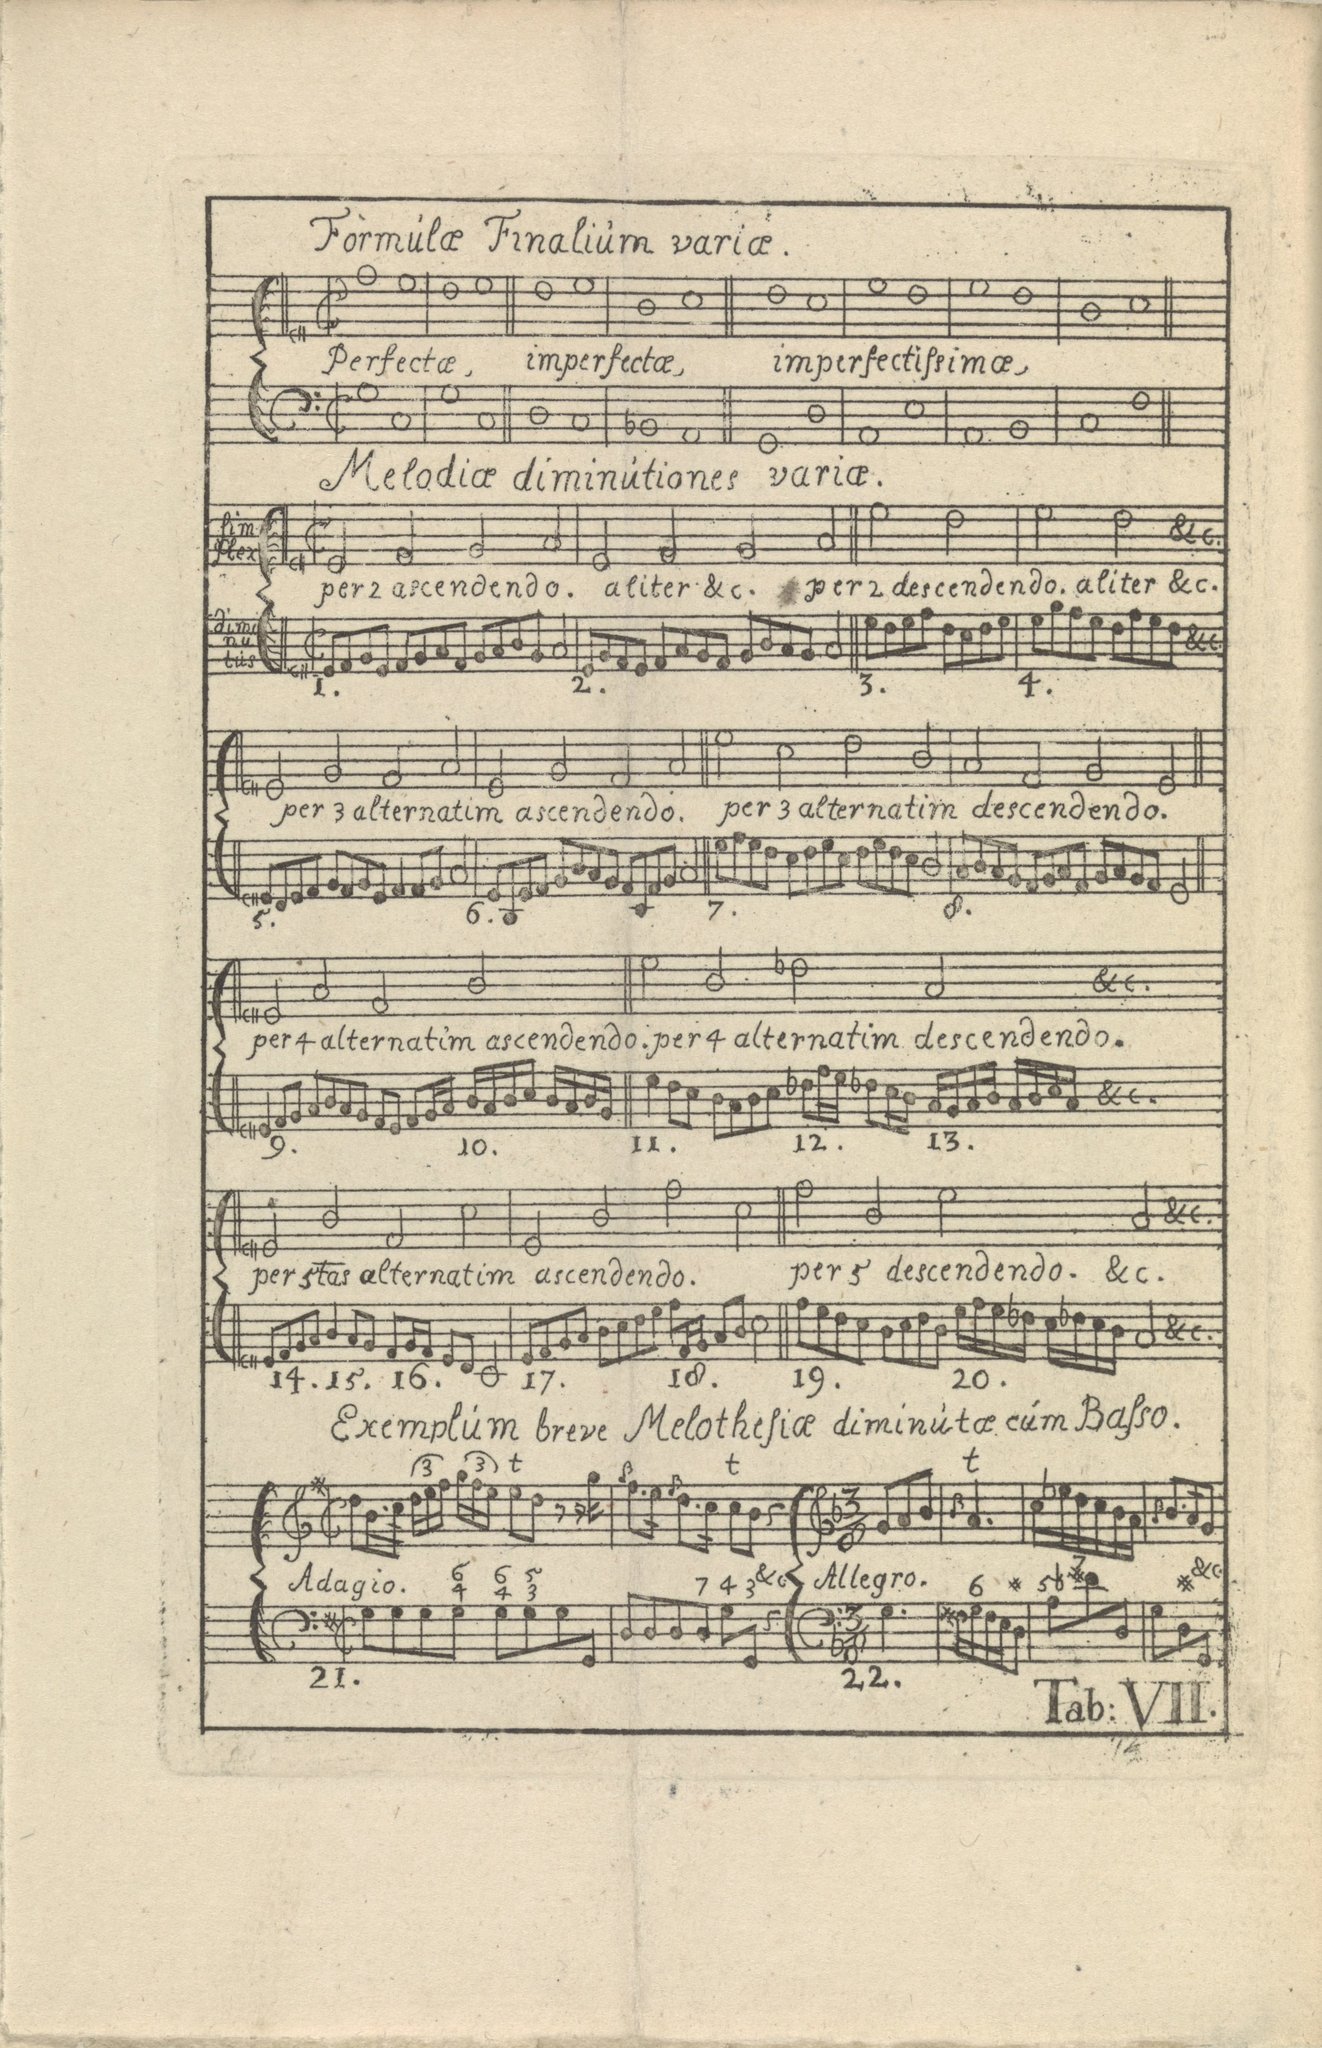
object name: book illustration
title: Bladmuziek Tab. VII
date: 1743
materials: paper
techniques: etching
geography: netherlands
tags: notation of music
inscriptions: collector's mark: Lugt 2760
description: Bladmuziek uit: Konrad Zumbach von Coesfeld, Institutiones musicæ, of Korte onderwyzingen rakende de practyk van de musyk; en inzonderheid van den generaalen bas [...] benevens de [...] gronden van de compositie, 1743. Rechtsonder: Tab. VII.